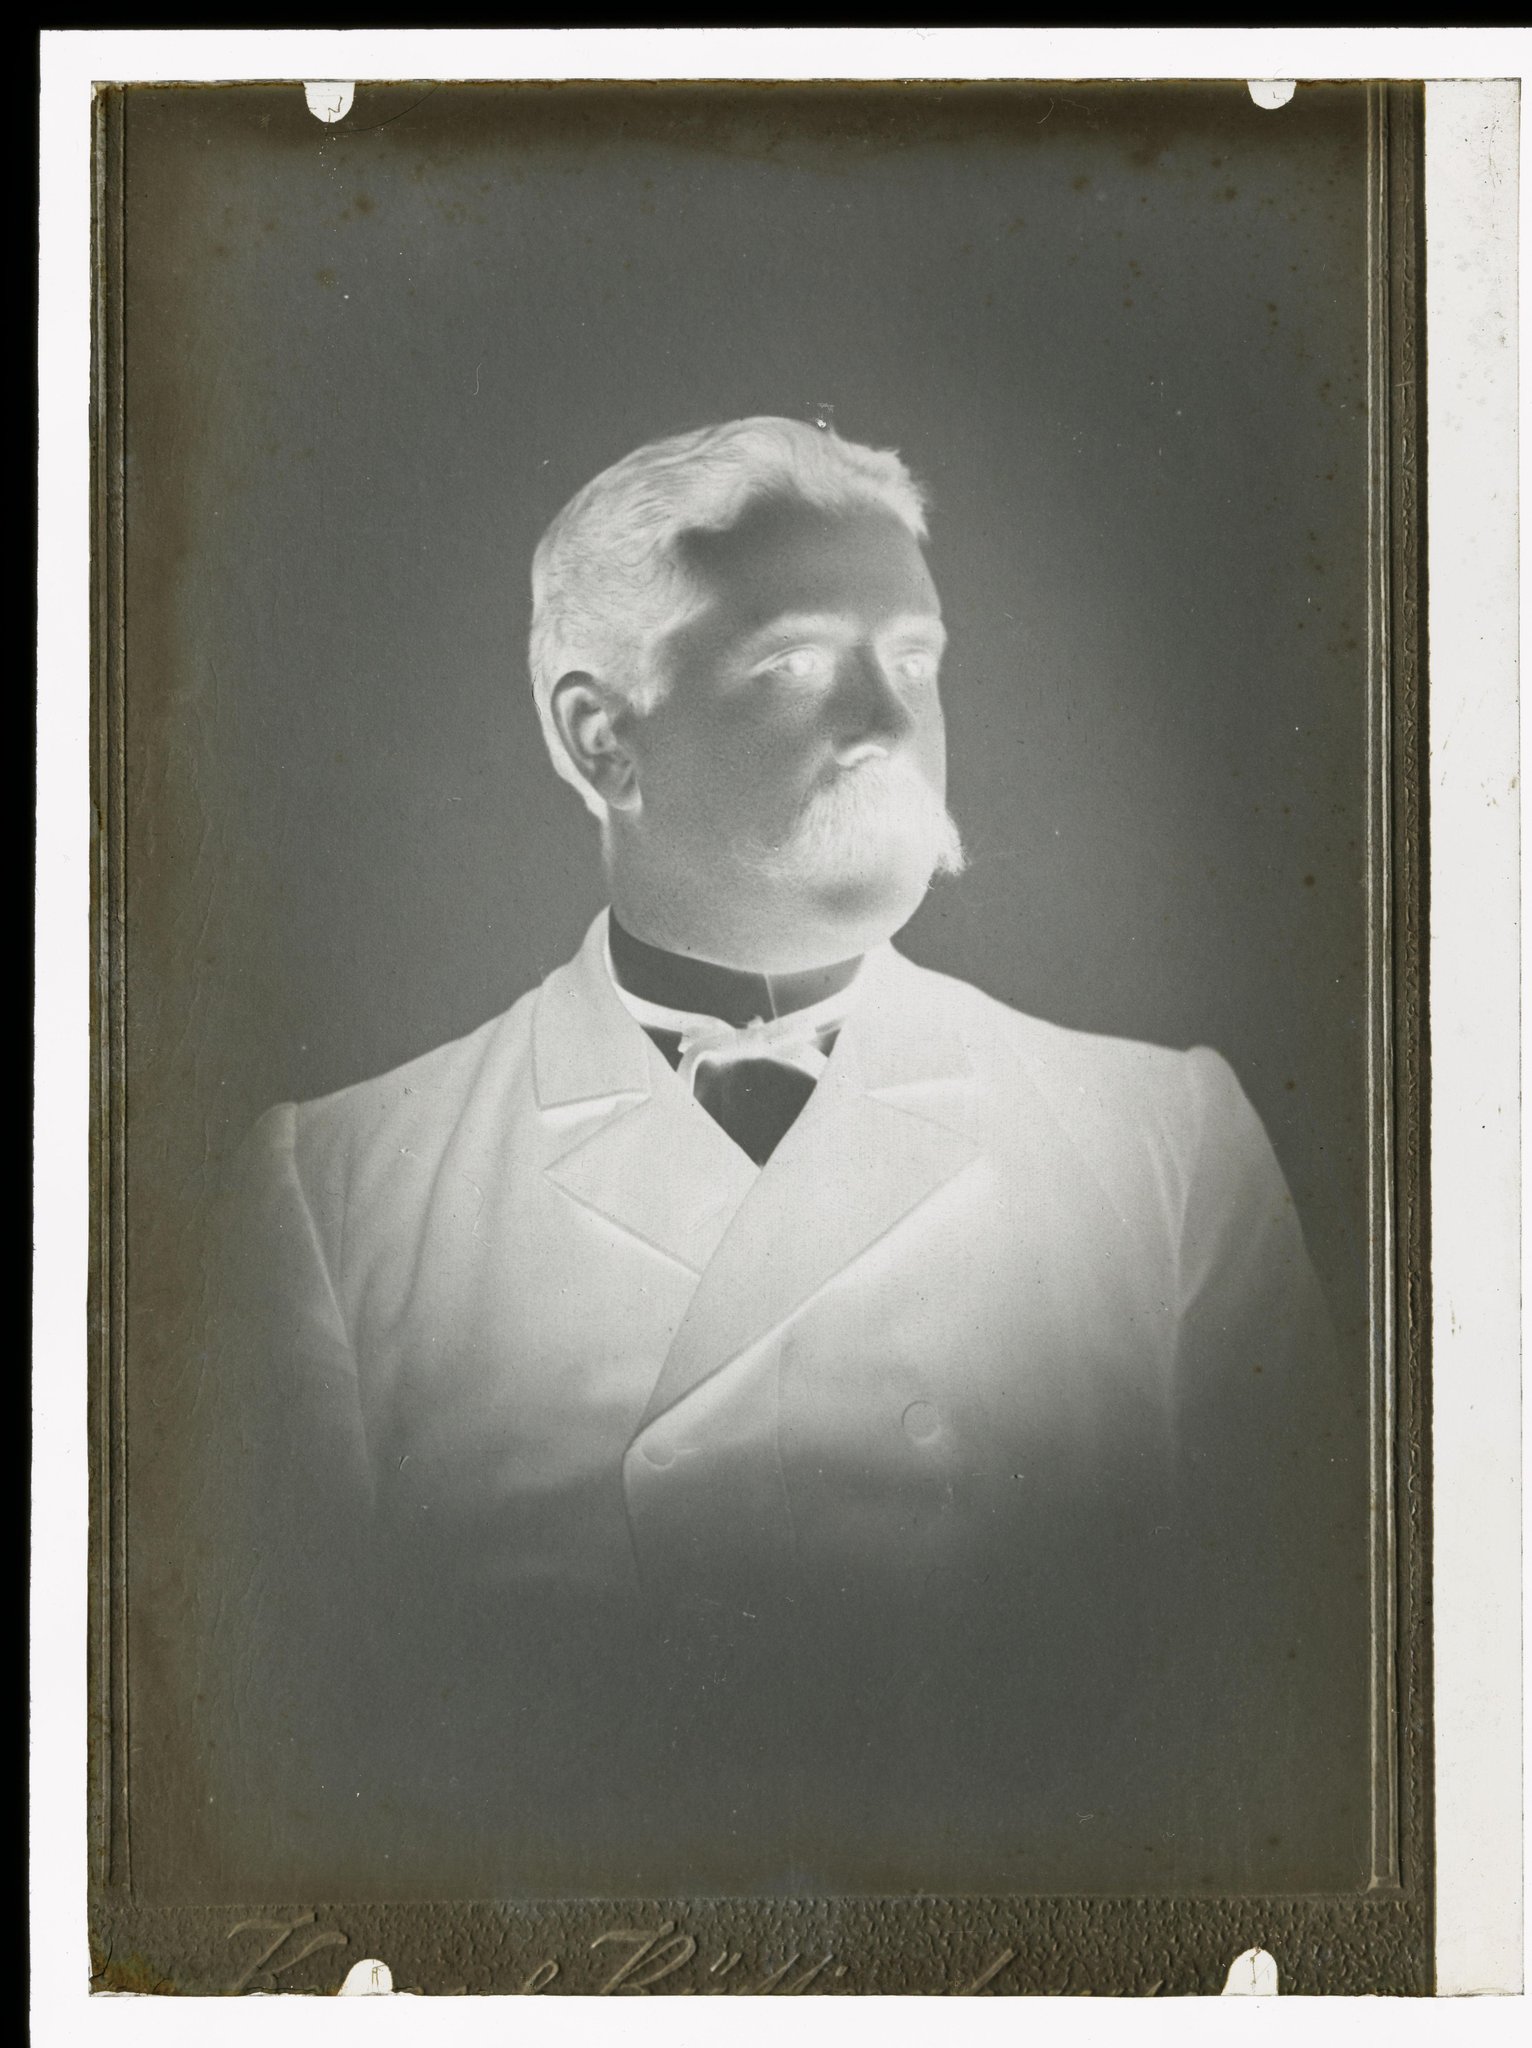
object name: glasnegatief, glasplaatnegatief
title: Portret van een onbekende man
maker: Anonymous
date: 1907-1935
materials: glass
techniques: gelatin glass negative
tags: historical persons not known by name